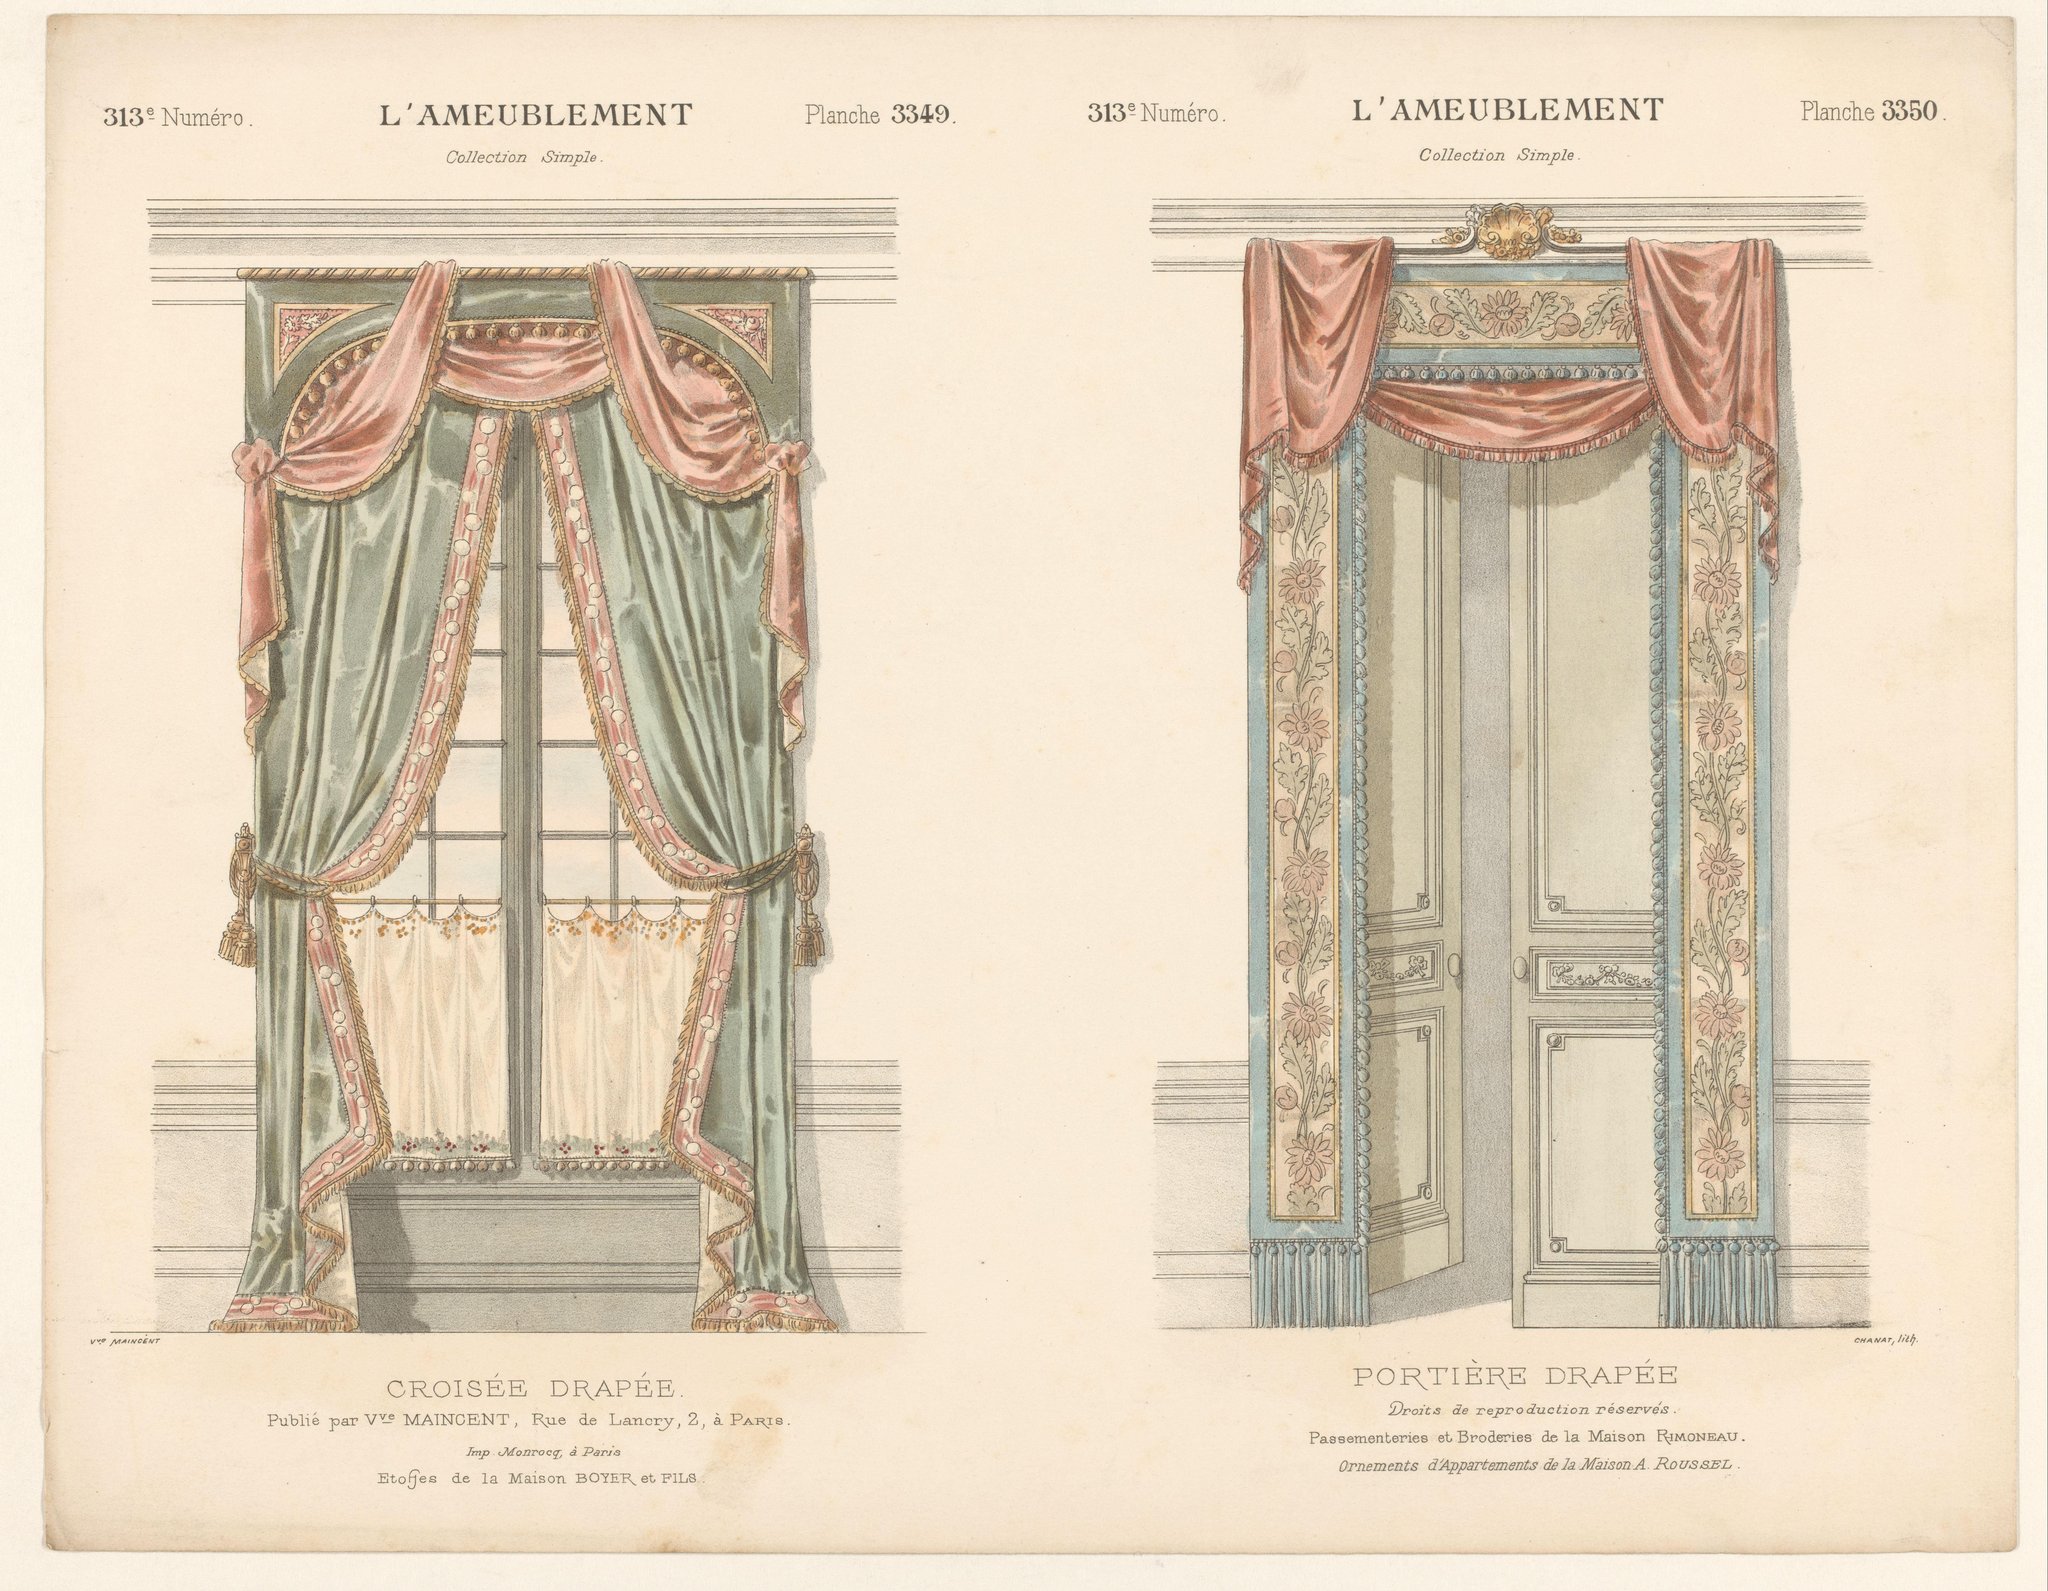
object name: print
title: L'ameublement / Collection simple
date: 1895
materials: paper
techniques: hand coloring, lithograph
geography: paris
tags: window, door, hangings and drapery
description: Een venster en deur met gedrapeerde gordijnen. Prent uit 313e Livraison.